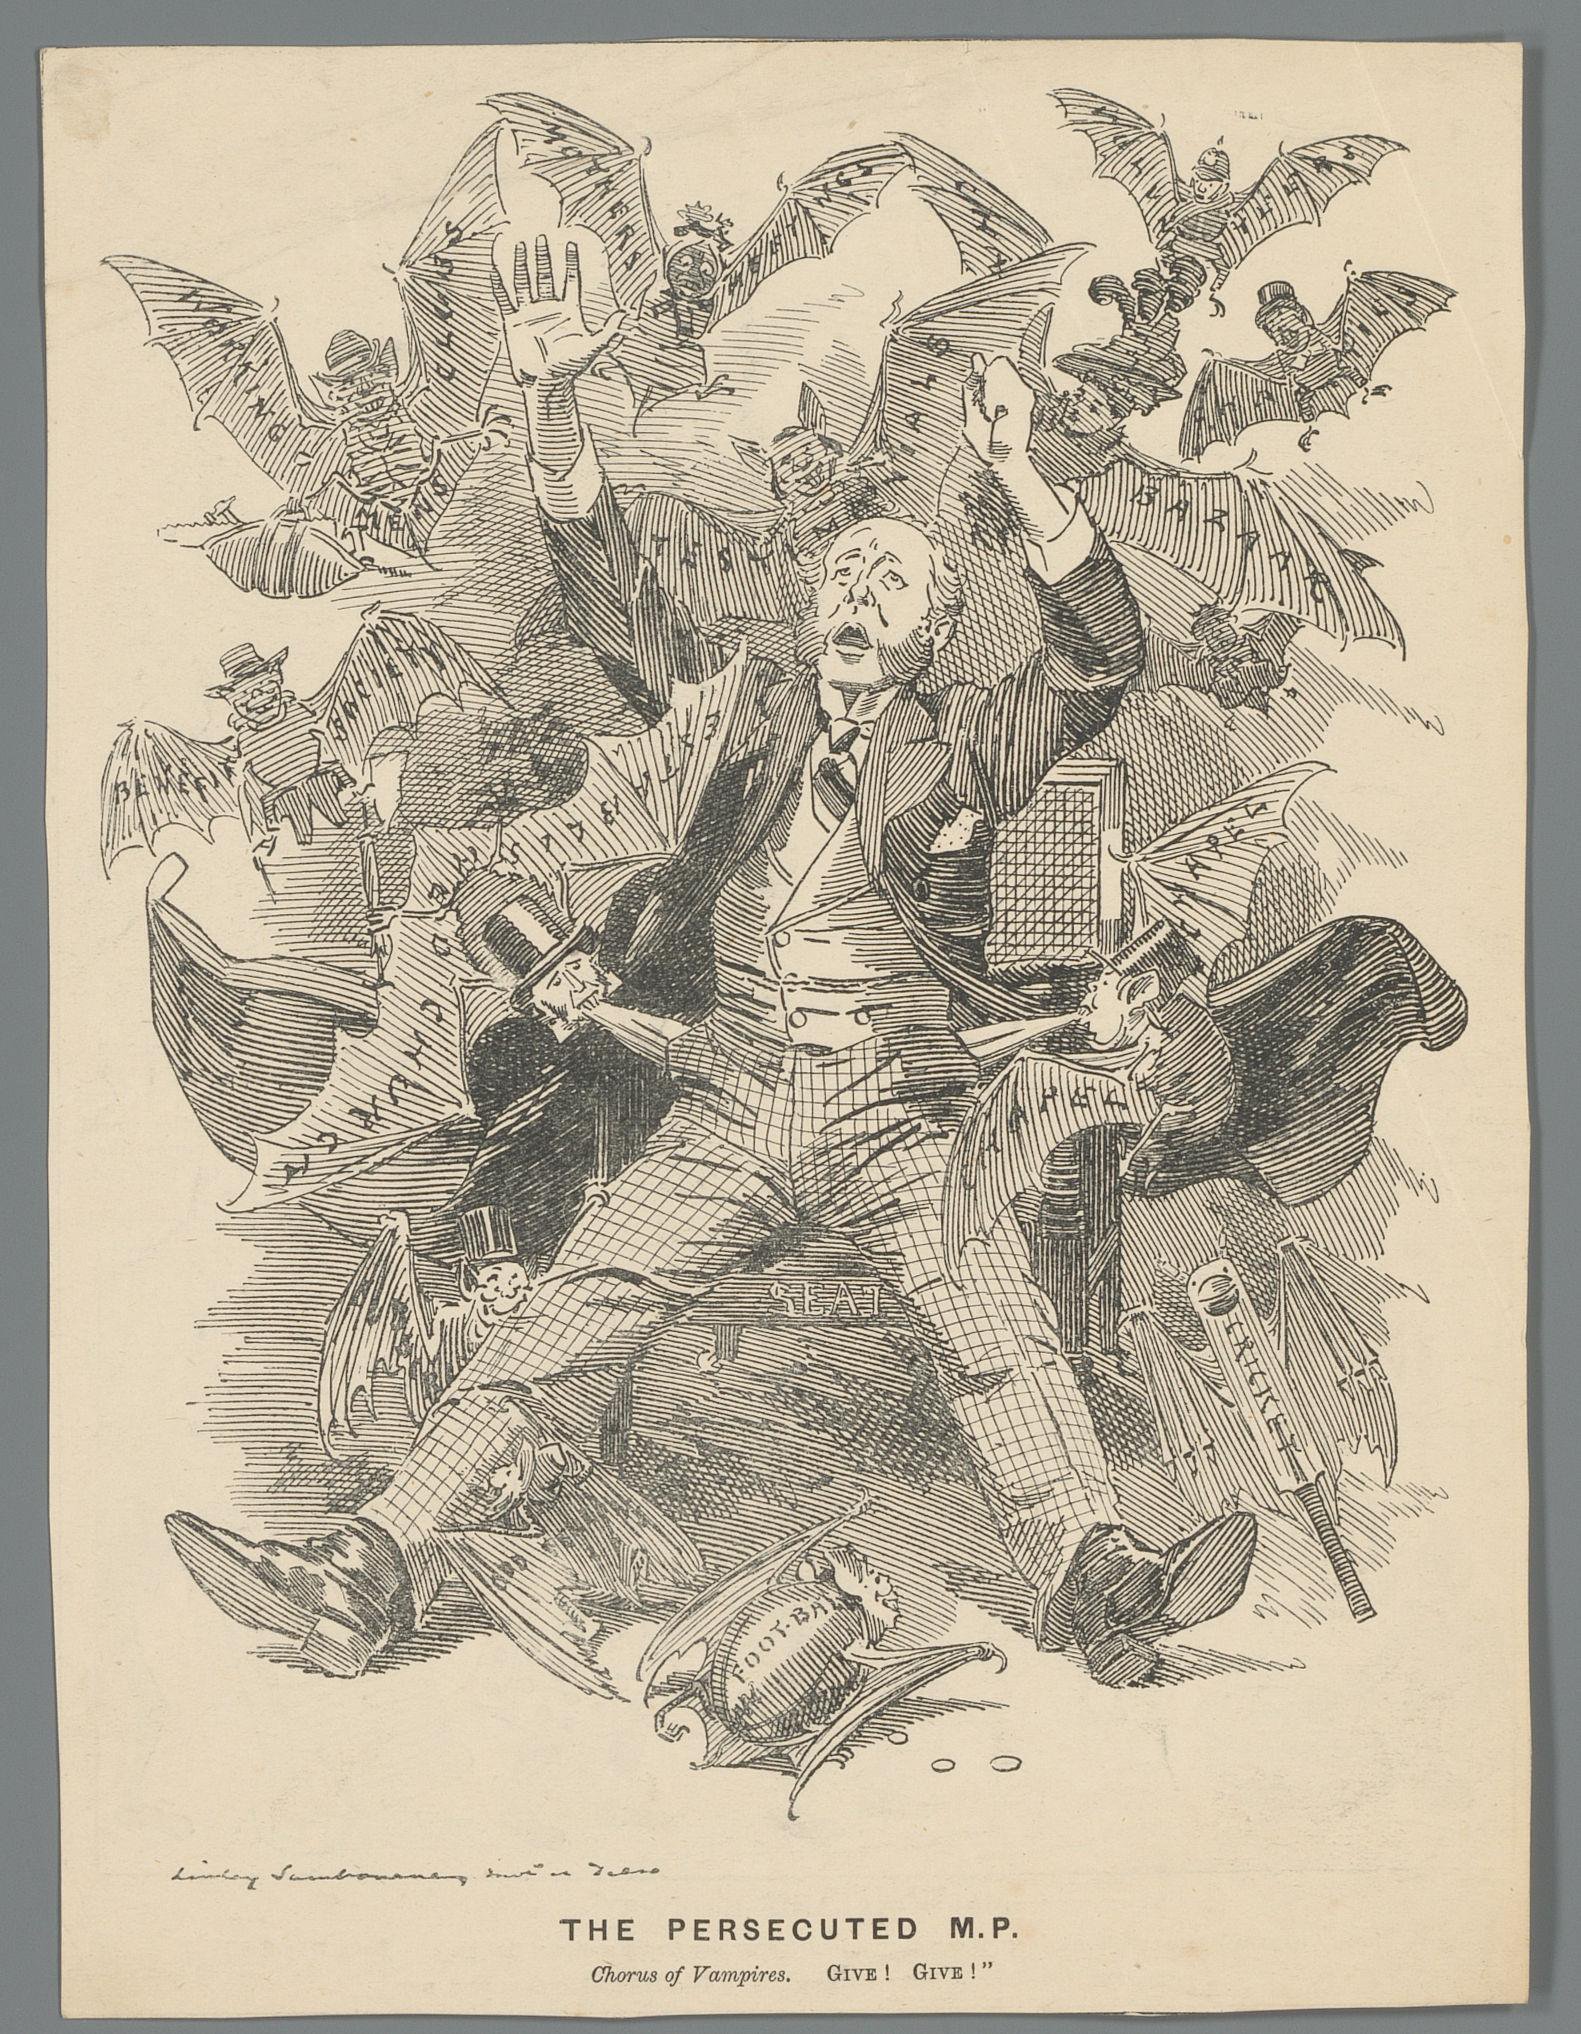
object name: print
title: The Persecuted M.P.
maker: edward linley sambourne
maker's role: draughtsman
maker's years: 1844-1910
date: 1898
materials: paper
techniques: line block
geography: england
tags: flying mammals: bat, member of parliament, political caricatures and satires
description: De vele plagen van een parlementariër (MP, member of parliament), voorgesteld als vampier vleermuizen die een man lastigvallen en, financieel, leegzuigen. Spotprent in het Engelse satirische tijdschrift Punch, 1898.